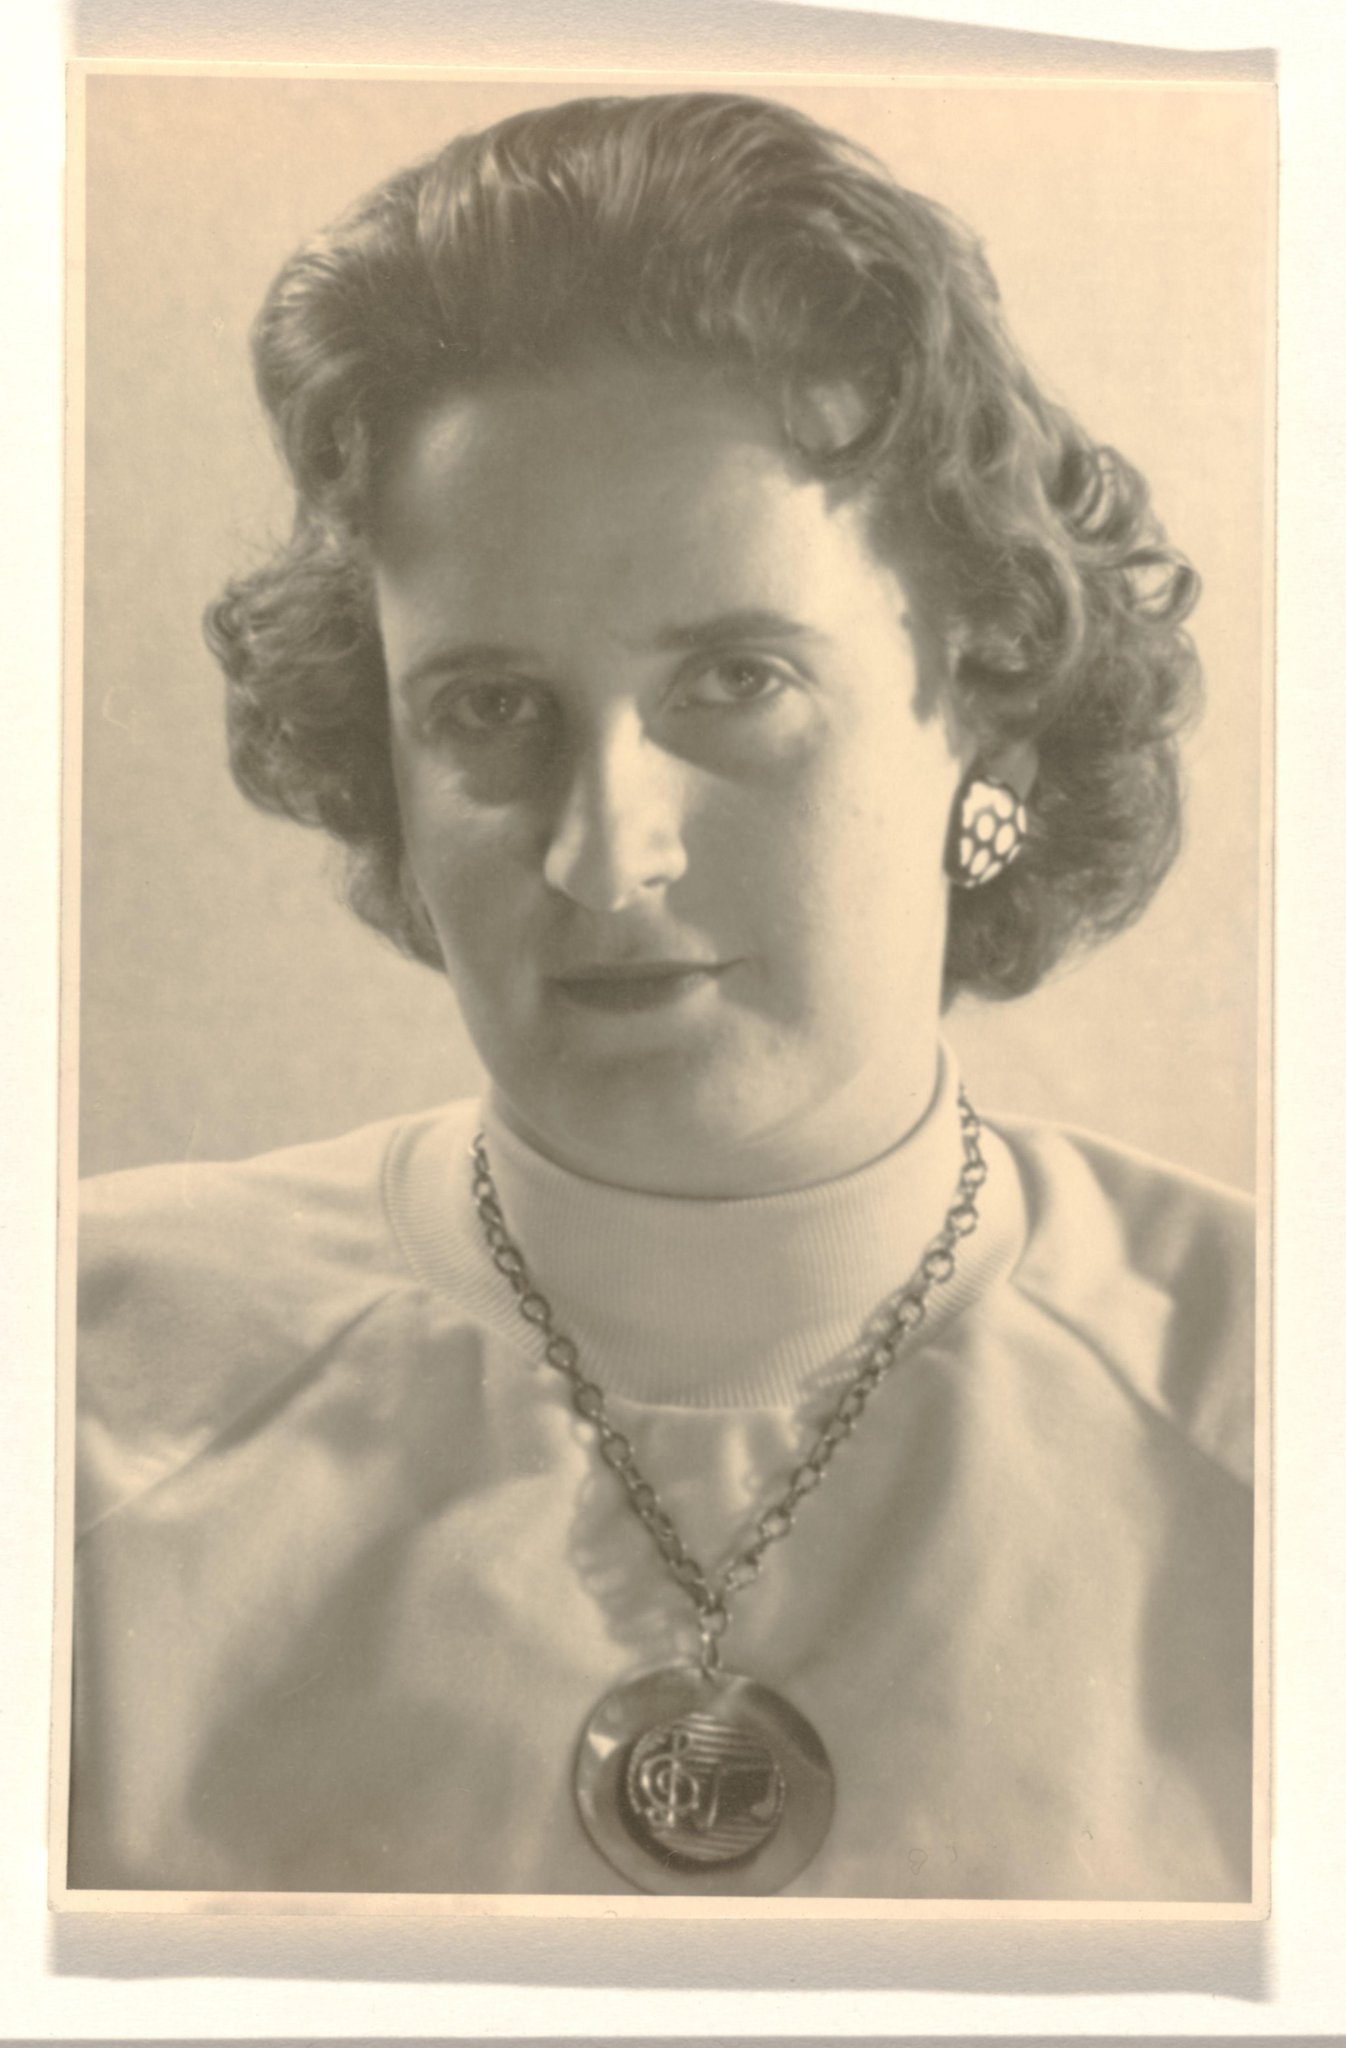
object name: photograph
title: Isabel Wachenheimer met coltrui en hanger met muzieknoten om haar nek, kijkend naar links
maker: Anonymous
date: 1956-1973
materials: photographic support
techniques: gelatin silver print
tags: leiden, isabel wachenheimer-elon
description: Isabel Wachenheimer met coltrui en hanger met muzieknoten om haar nek, kijkend naar links.